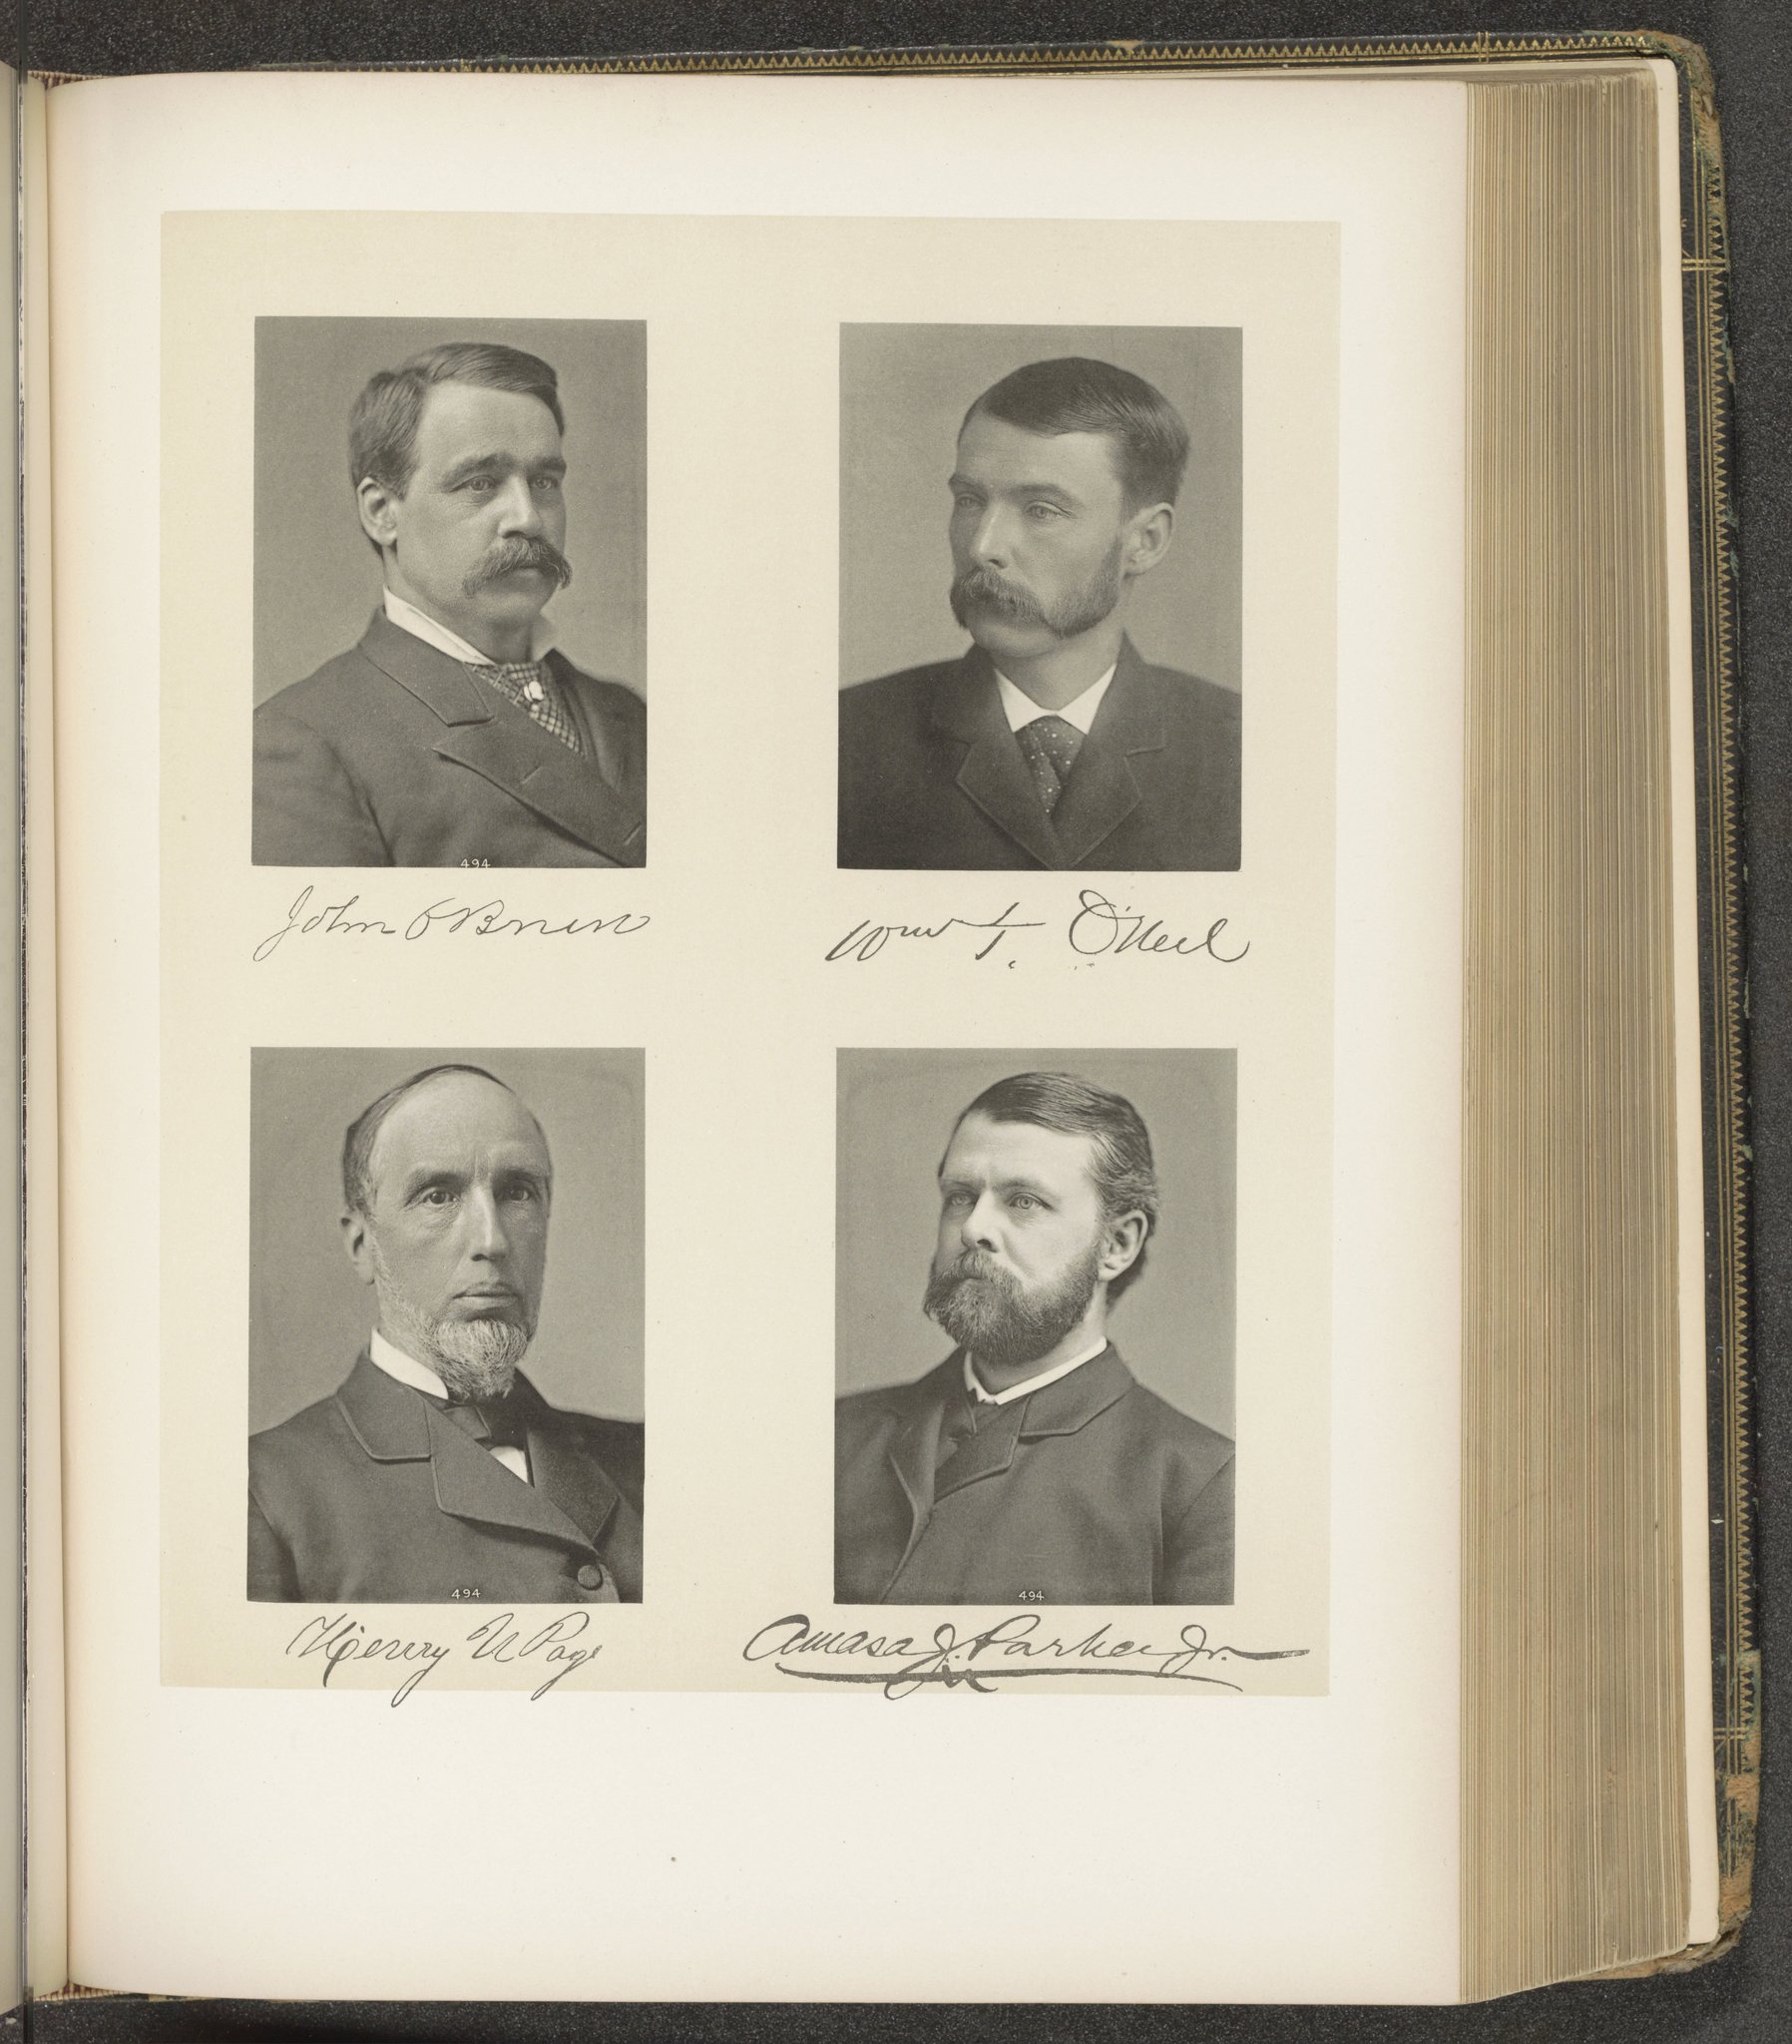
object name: page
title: Portretten van vier leden van het Lagerhuis van de staat New York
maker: Anonymous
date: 1872-1882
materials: paper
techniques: photograph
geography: united states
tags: historical persons (portraits and scenes from the life) (+ head (and shoulders) (portrait))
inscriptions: annotation, number: ‘494’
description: Linksboven John O'Brien, rechtsboven William Thomas O'Neill, linksonder Henry N. Page, rechtsonder Amasa J. Parker.